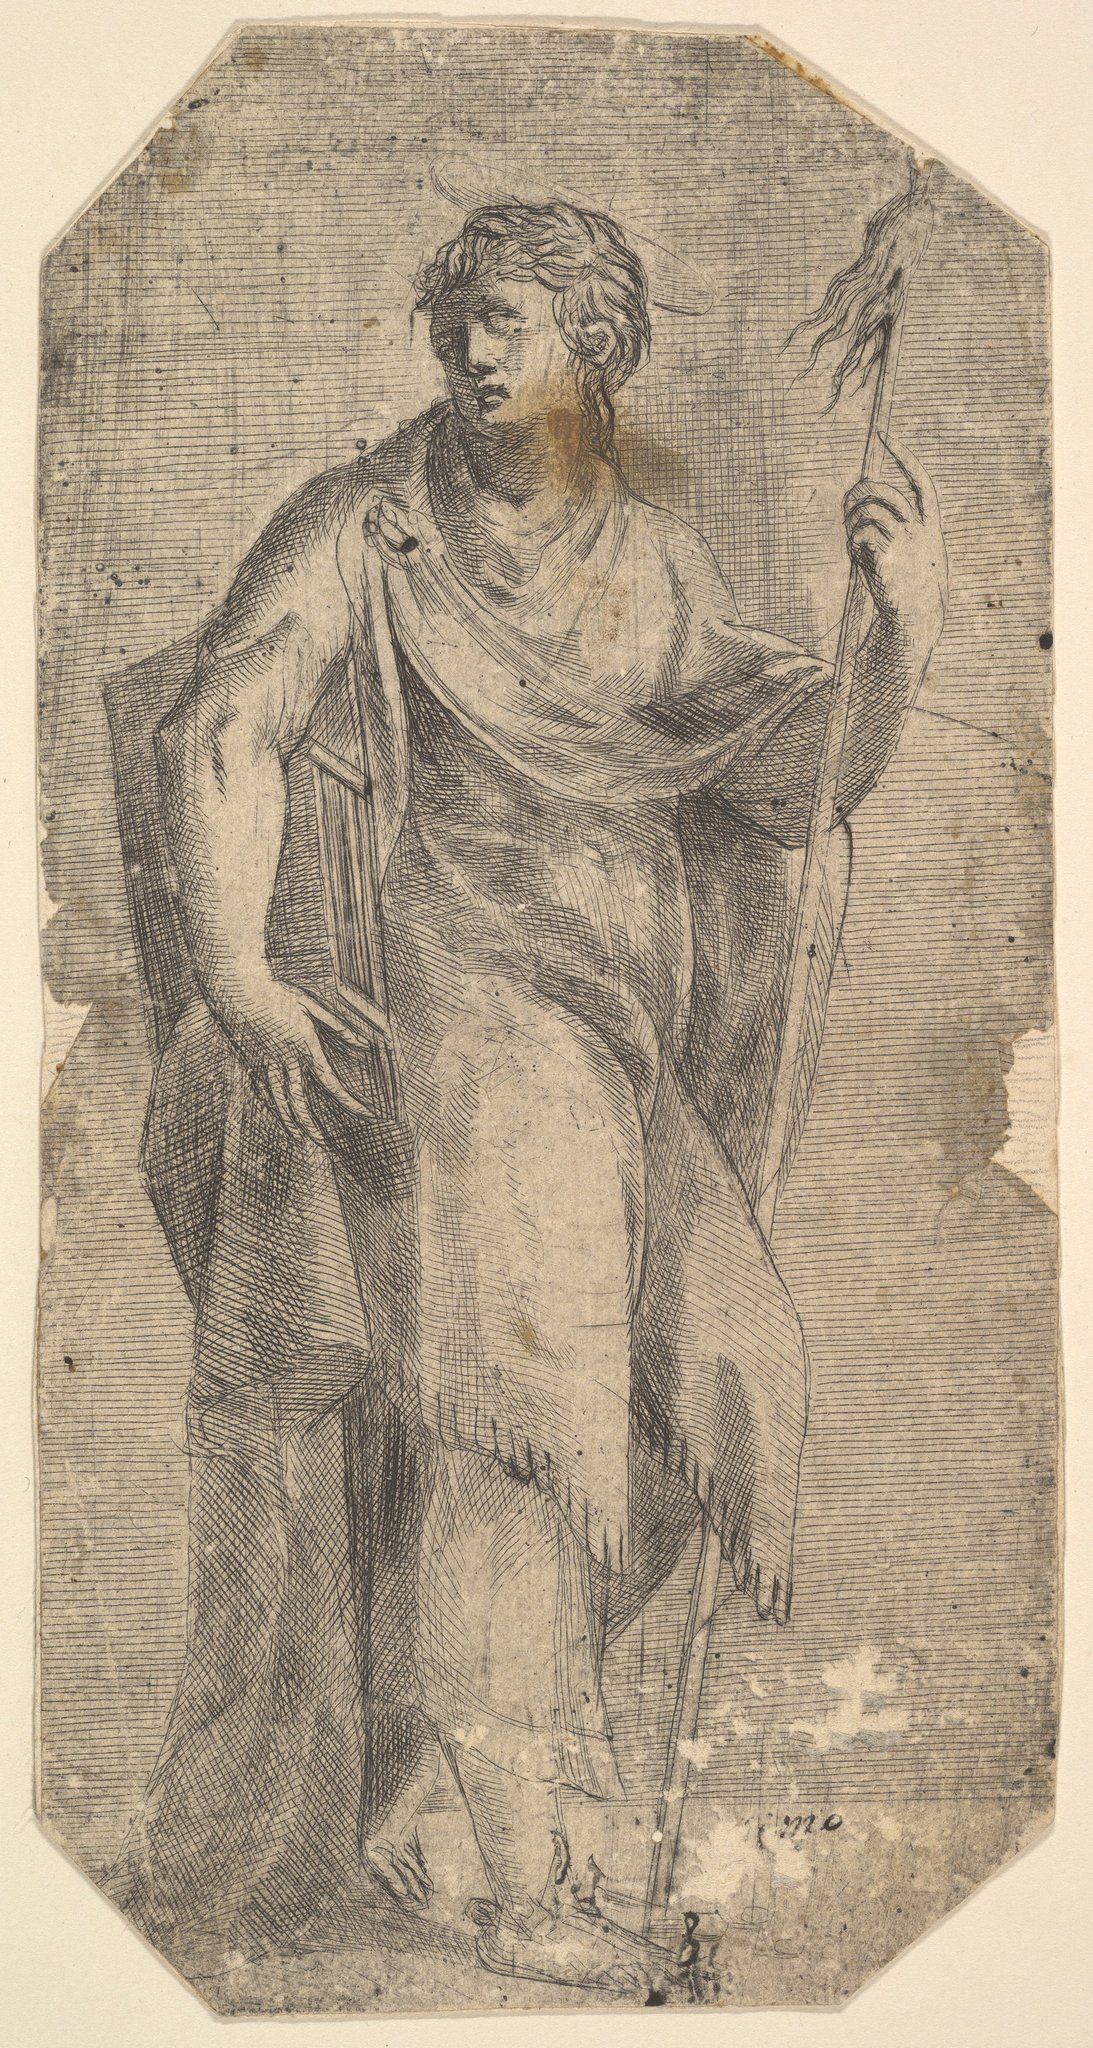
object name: print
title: Saint Matthew holding a staff and a book, turning to the left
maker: andrea schiavone (andrea meldola)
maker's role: artist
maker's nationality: italian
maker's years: 1510-1563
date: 1540-1550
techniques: etching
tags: books,saint matthew